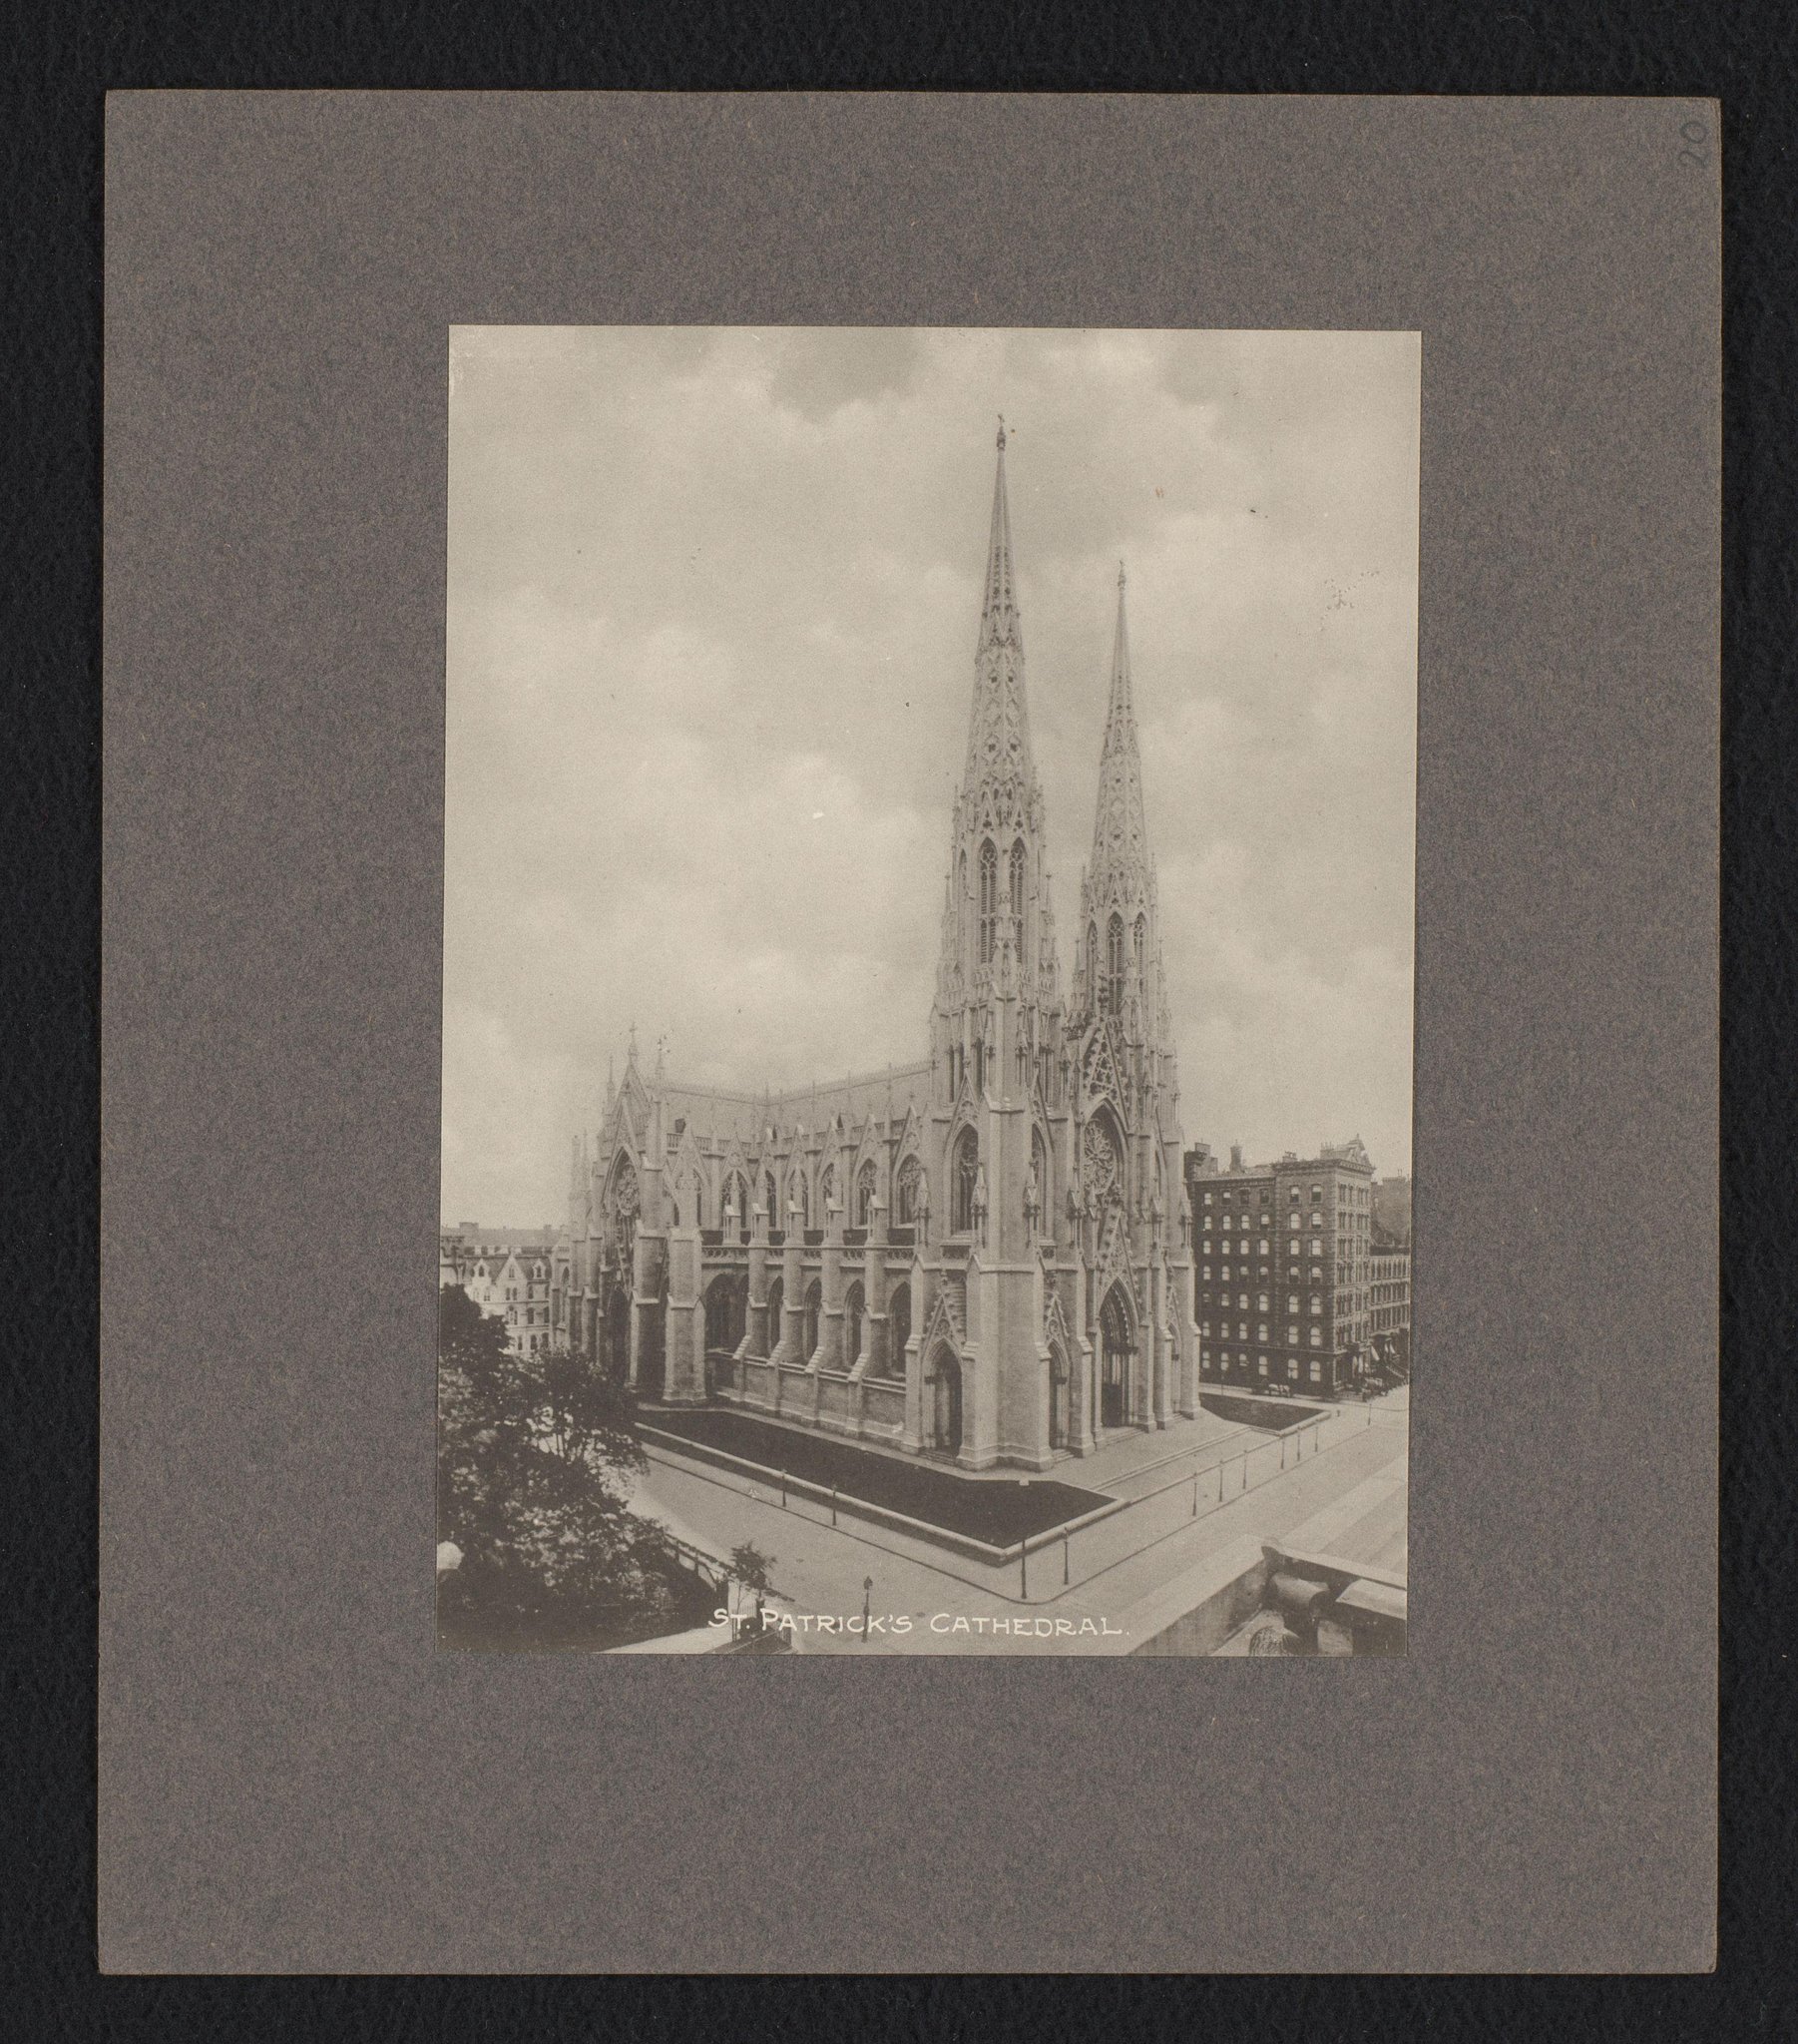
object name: photomechanical print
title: Gezicht op Saint Patrick's Cathedral, New York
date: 1902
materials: paper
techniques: photograph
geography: new york city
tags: church (exterior)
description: Deze prent maakt deel uit van een album.